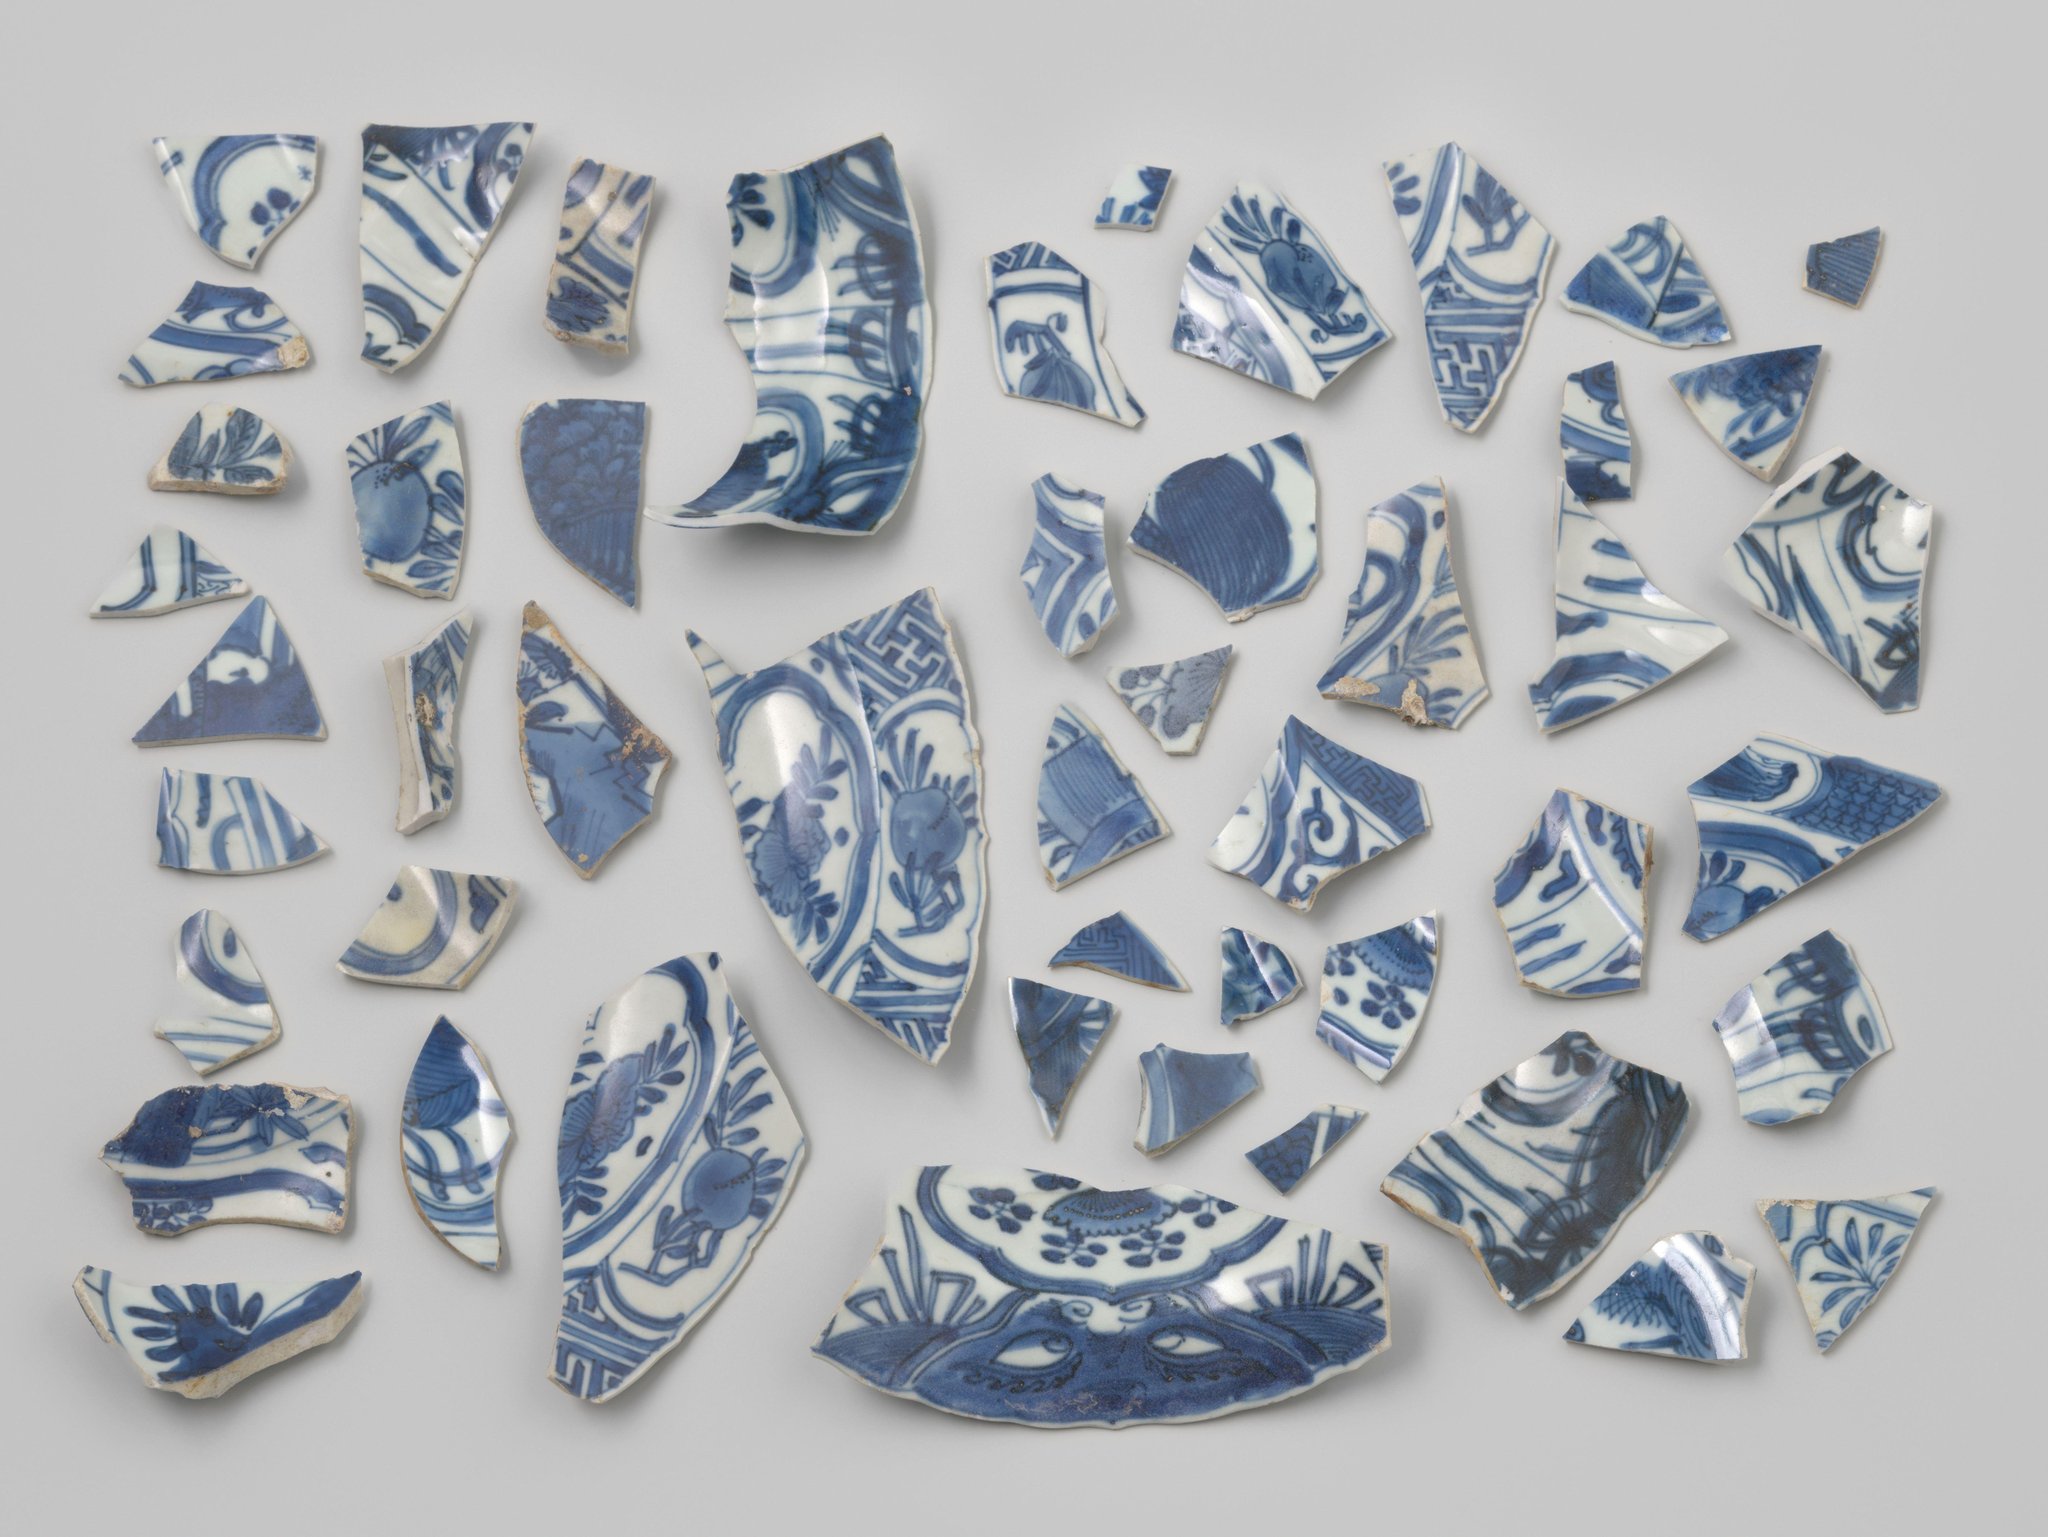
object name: sherd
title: Scherven kraakporselein uit V.O.C.-schip de 'Witte Leeuw'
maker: Anonymous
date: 1613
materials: bone china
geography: jingdezhen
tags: verenigde oostindische compagnie, sint-helena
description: Scherven kraakporseleinen borden uit V.O.C.-schip de 'Witte Leeuw'.